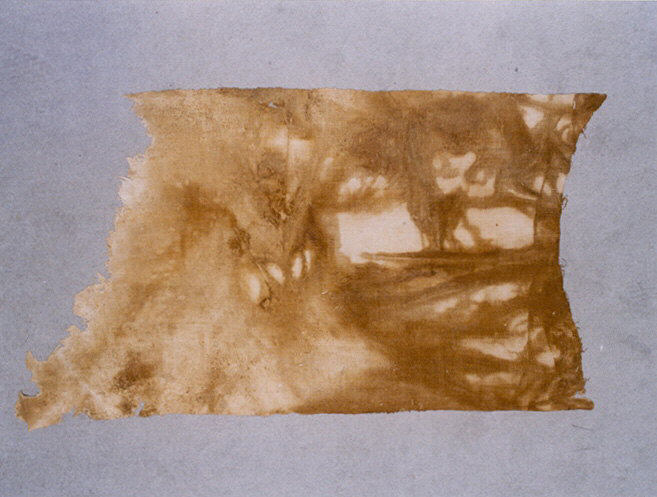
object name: textile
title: Garment fragment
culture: alanic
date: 601-900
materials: linen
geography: caucasus